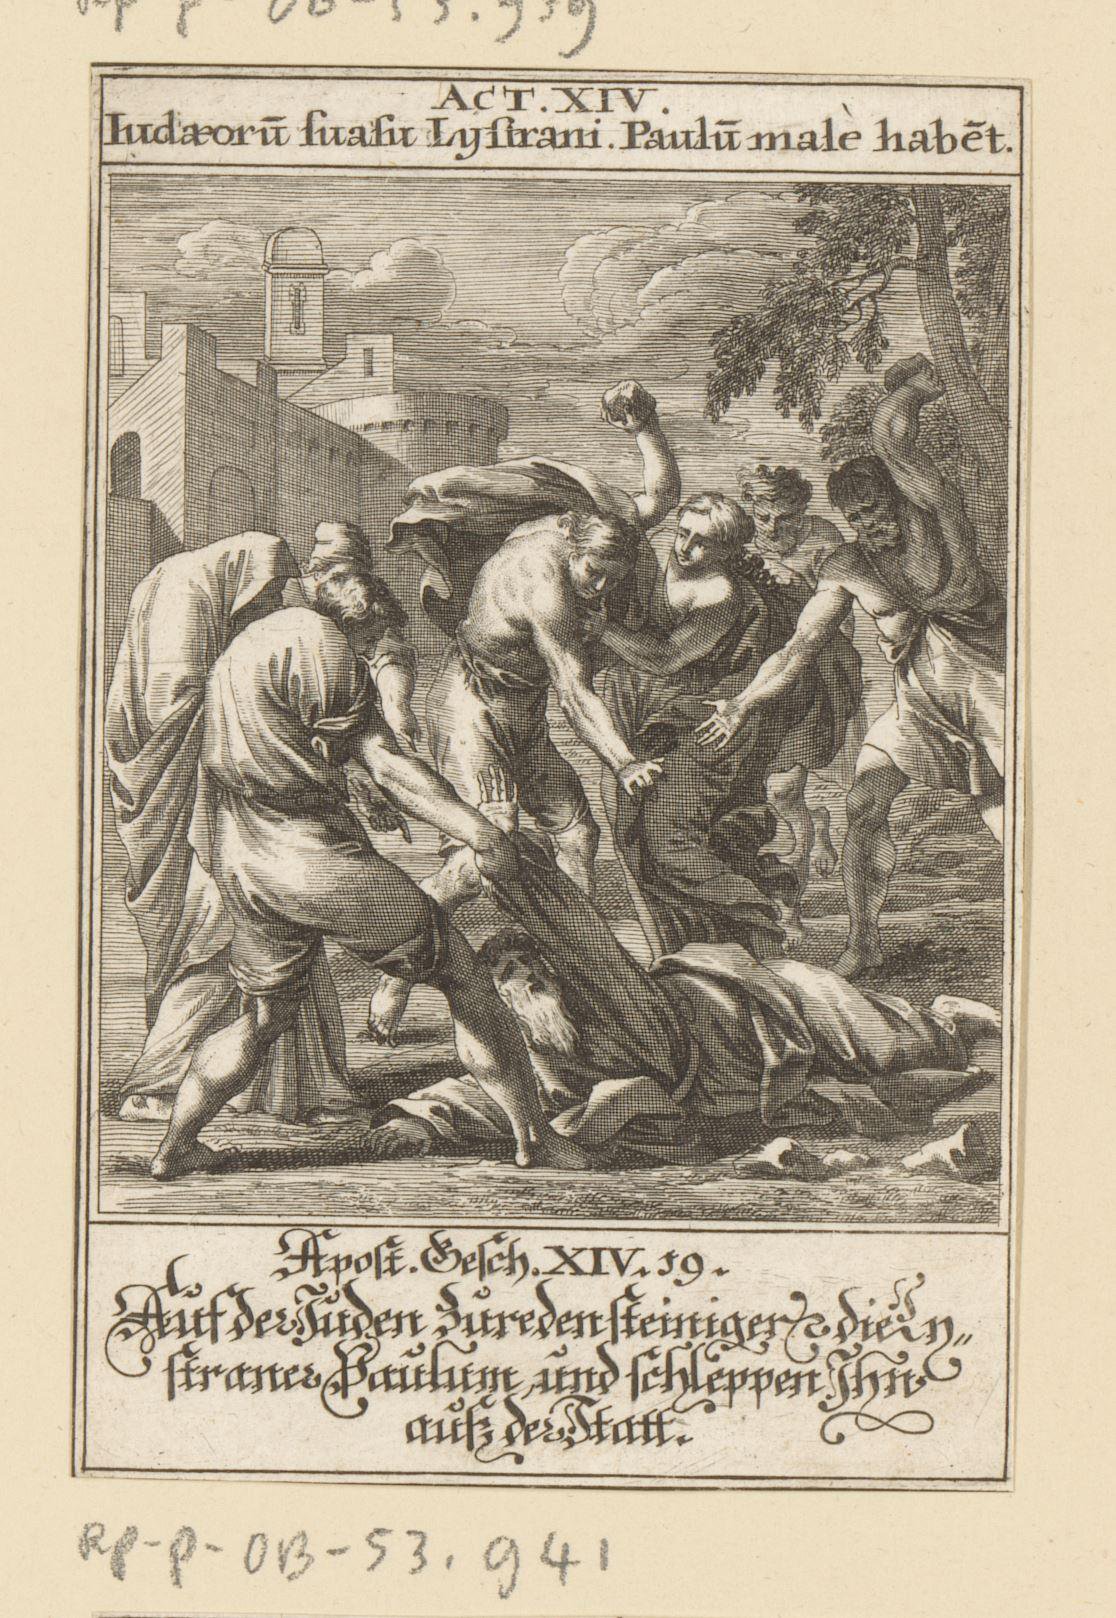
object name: print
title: Apostel Paulus gestenigd en weggesleept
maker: Anonymous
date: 1697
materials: paper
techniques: etching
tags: paul is stoned and dragged out of the city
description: Prent ook gebruikt in: Biblia ectypa : Bildnussen auss Heiliger Schrifft. Regensburg: Chr. Wiegel, 1697.